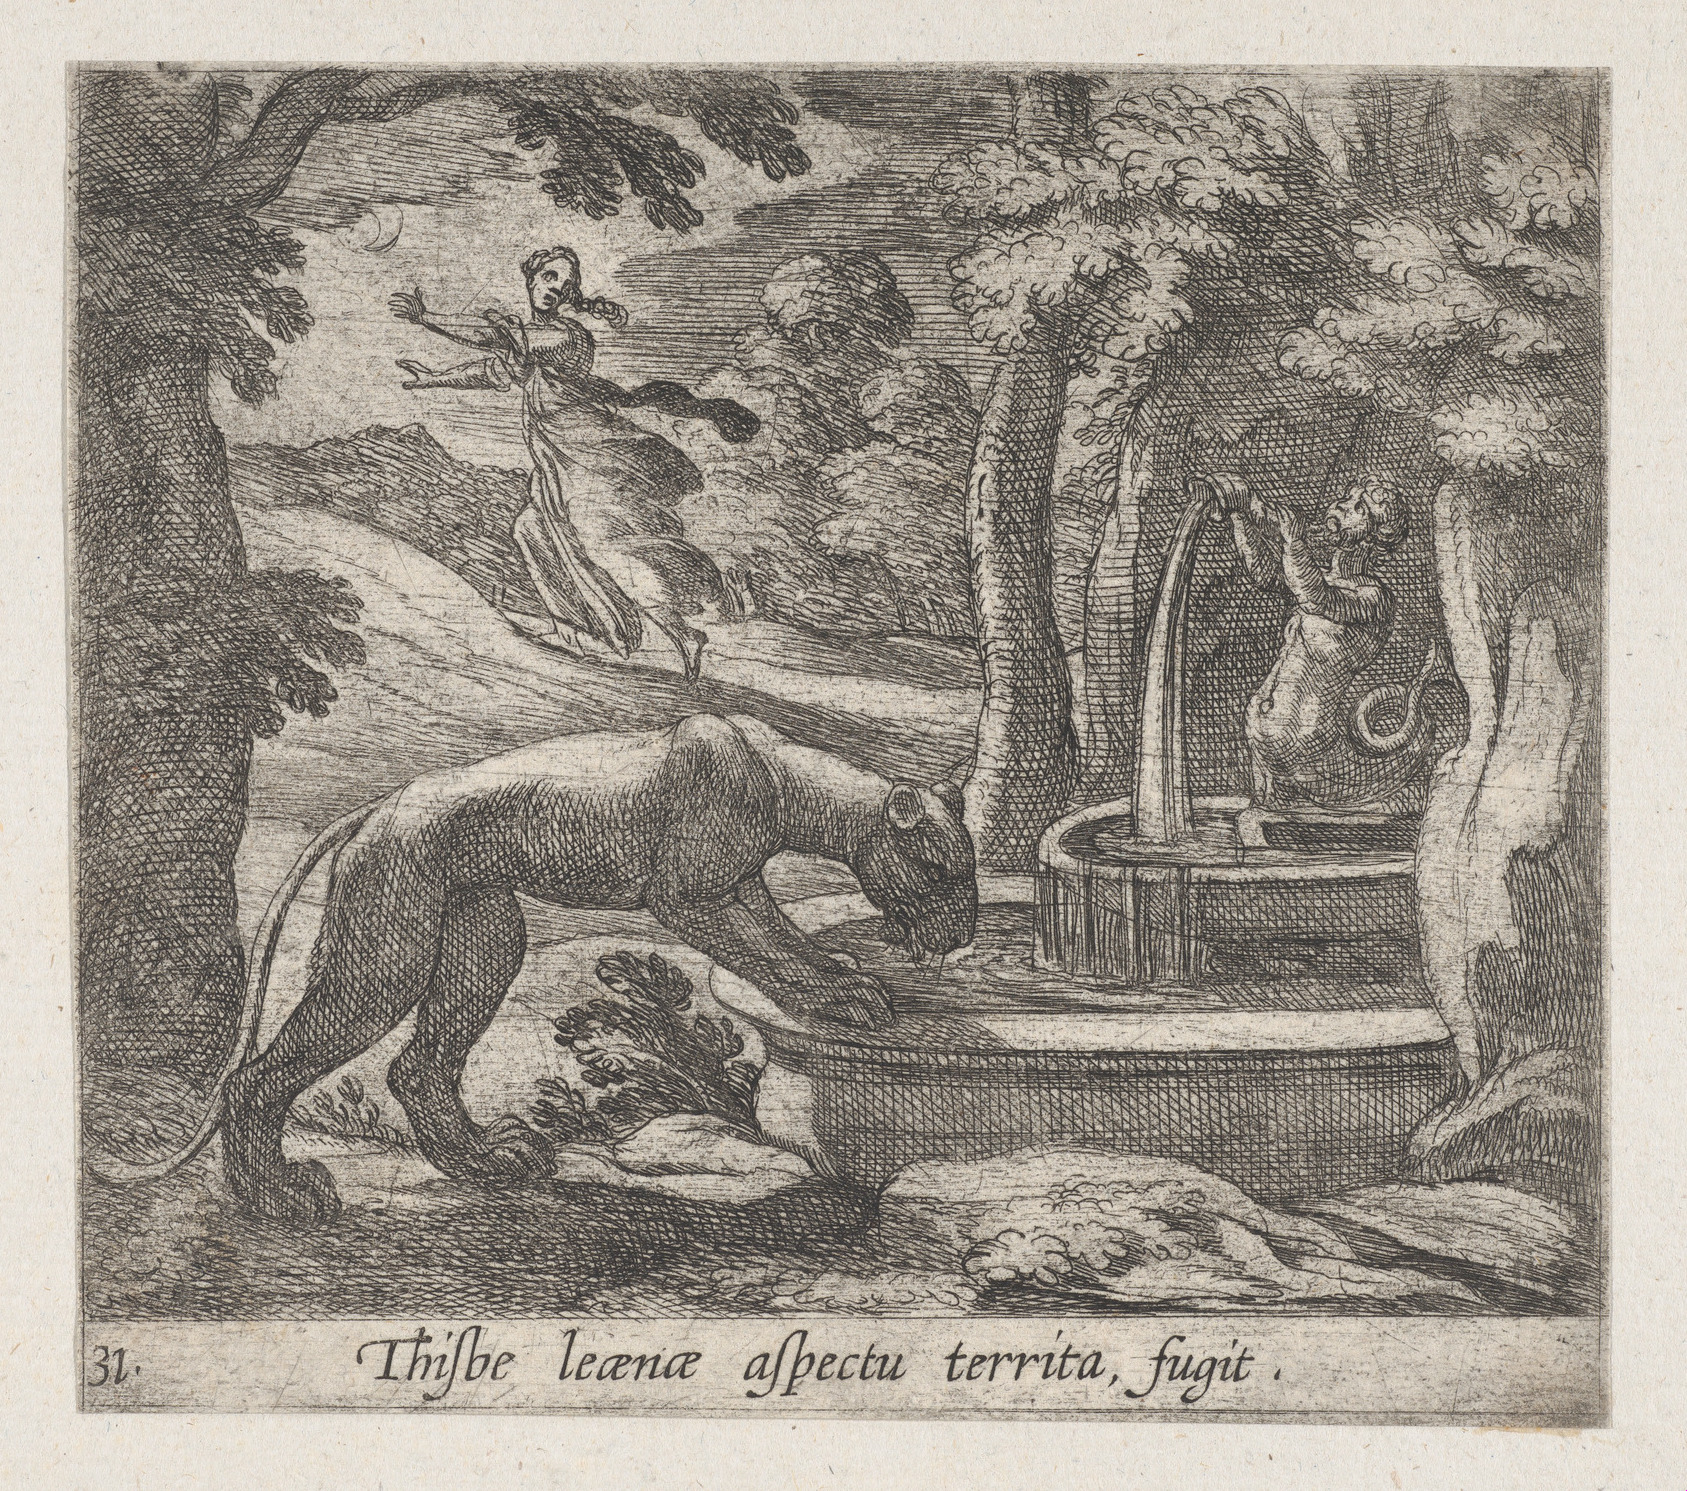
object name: print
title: Plate 31: Thisbe Running from the Lionness at the Well (Thisbe leaenae spectu territa fugit), from Ovid's 'Metamorphoses'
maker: antonio tempesta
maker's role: artist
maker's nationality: italian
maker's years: 1555-1630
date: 1606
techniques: etching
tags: wells,fear,women,lions